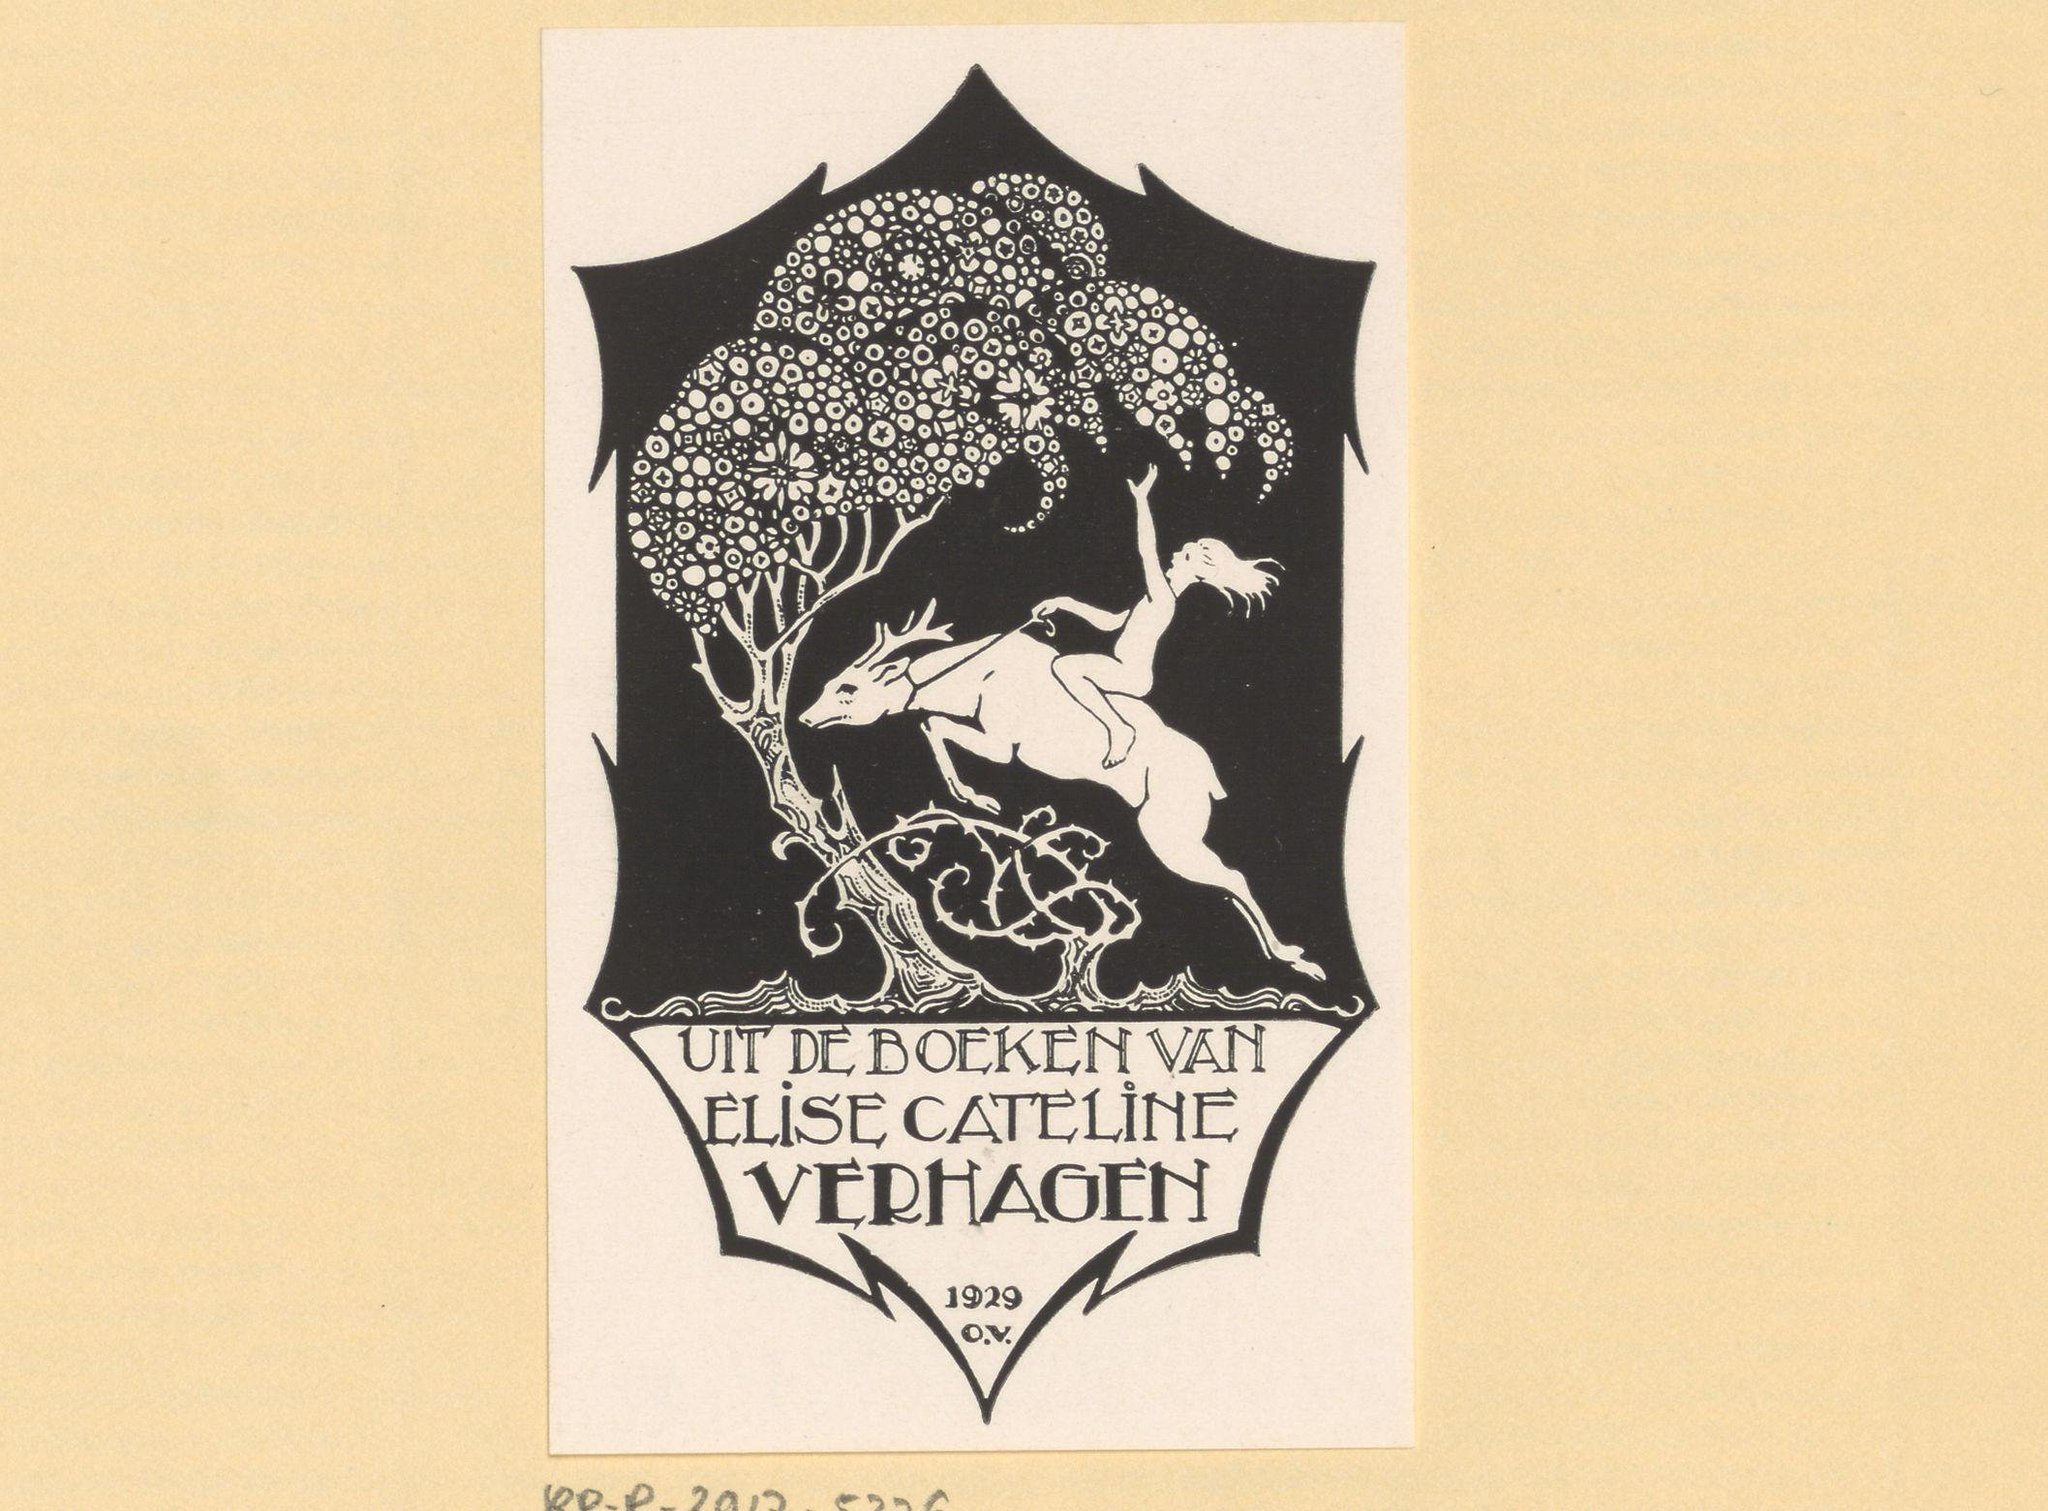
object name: bookplate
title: Ex libris van Elise Cateline Verhagen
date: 1929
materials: paper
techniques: printing block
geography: netherlands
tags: trees, hoofed animals: deer, riding on animal other than horse, ass, or mule, girl (child between toddler and youth)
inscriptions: inscription: ‘cliché 1929 / Otto Verhagen’